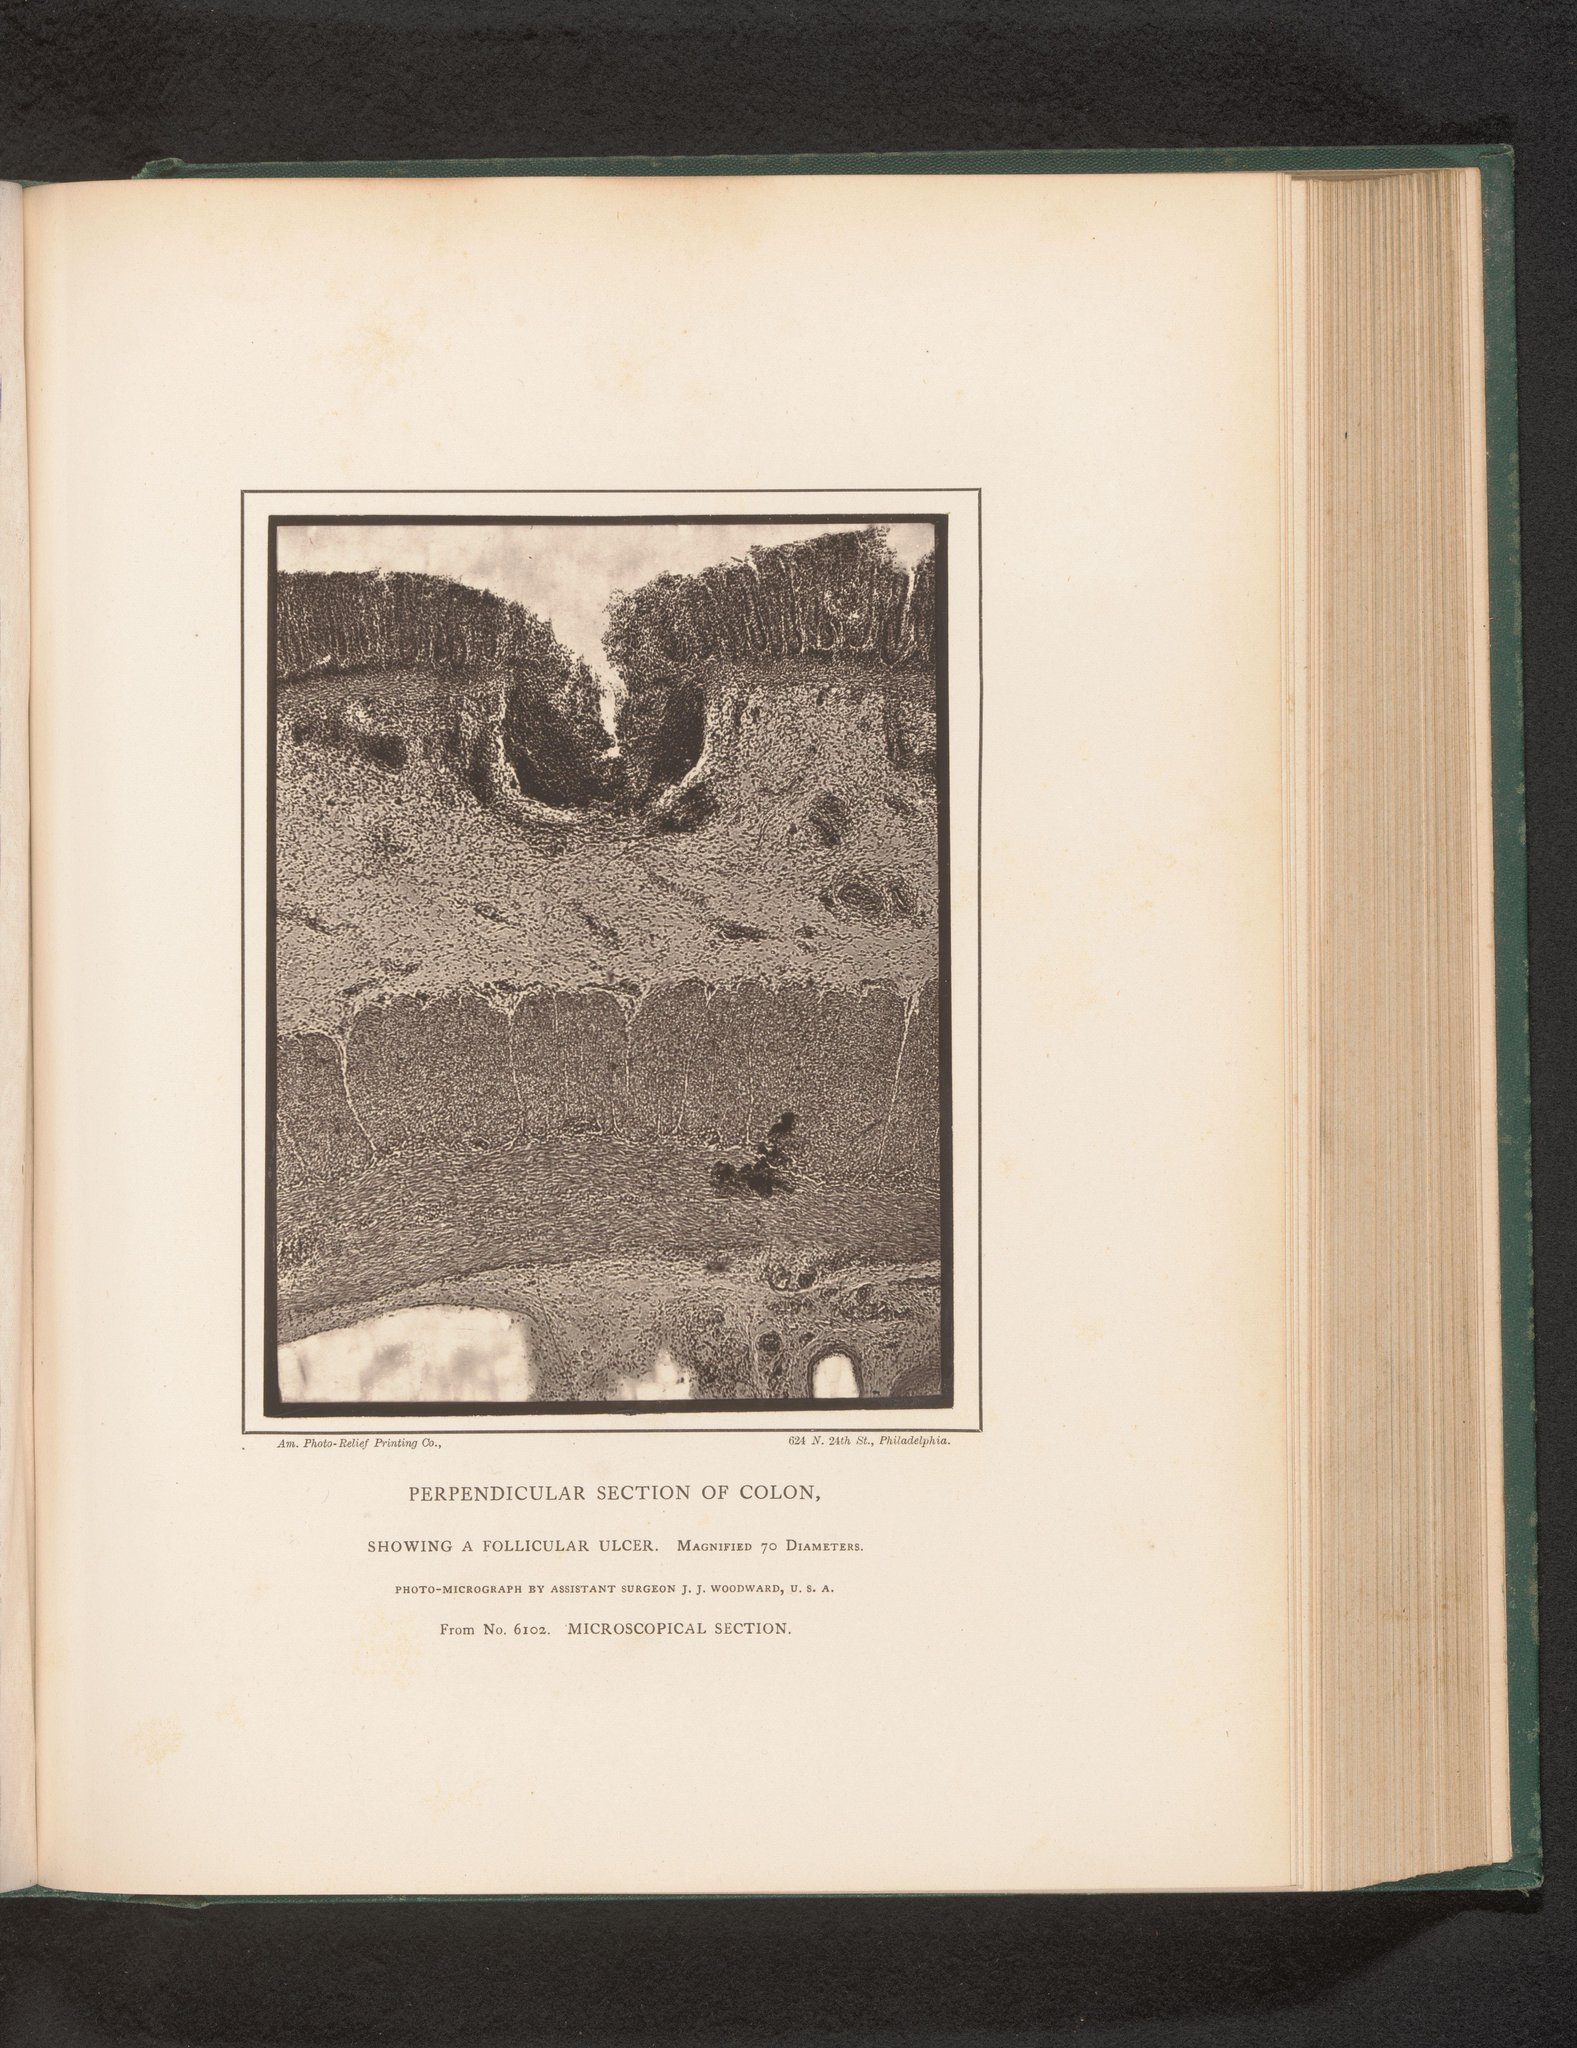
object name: page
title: Perpendicular Section of Colon, Showing a Follicular Ulcer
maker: joseph janvier woodward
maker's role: chirurg, fotograaf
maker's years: 1833-1884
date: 1874-1879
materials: paper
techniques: woodburytype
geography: philadelphia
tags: intestines, ulcer, anatomical specimen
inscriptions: address: ‘624 N. 24th St., Philadelphia.’, inscription: ‘Magnified 70 Diameters./ Photo-micrograph by assistant surgeon J. J. Woodward, U. S. A./ From No. 6102. MICROSCOPICAL SECTION.’